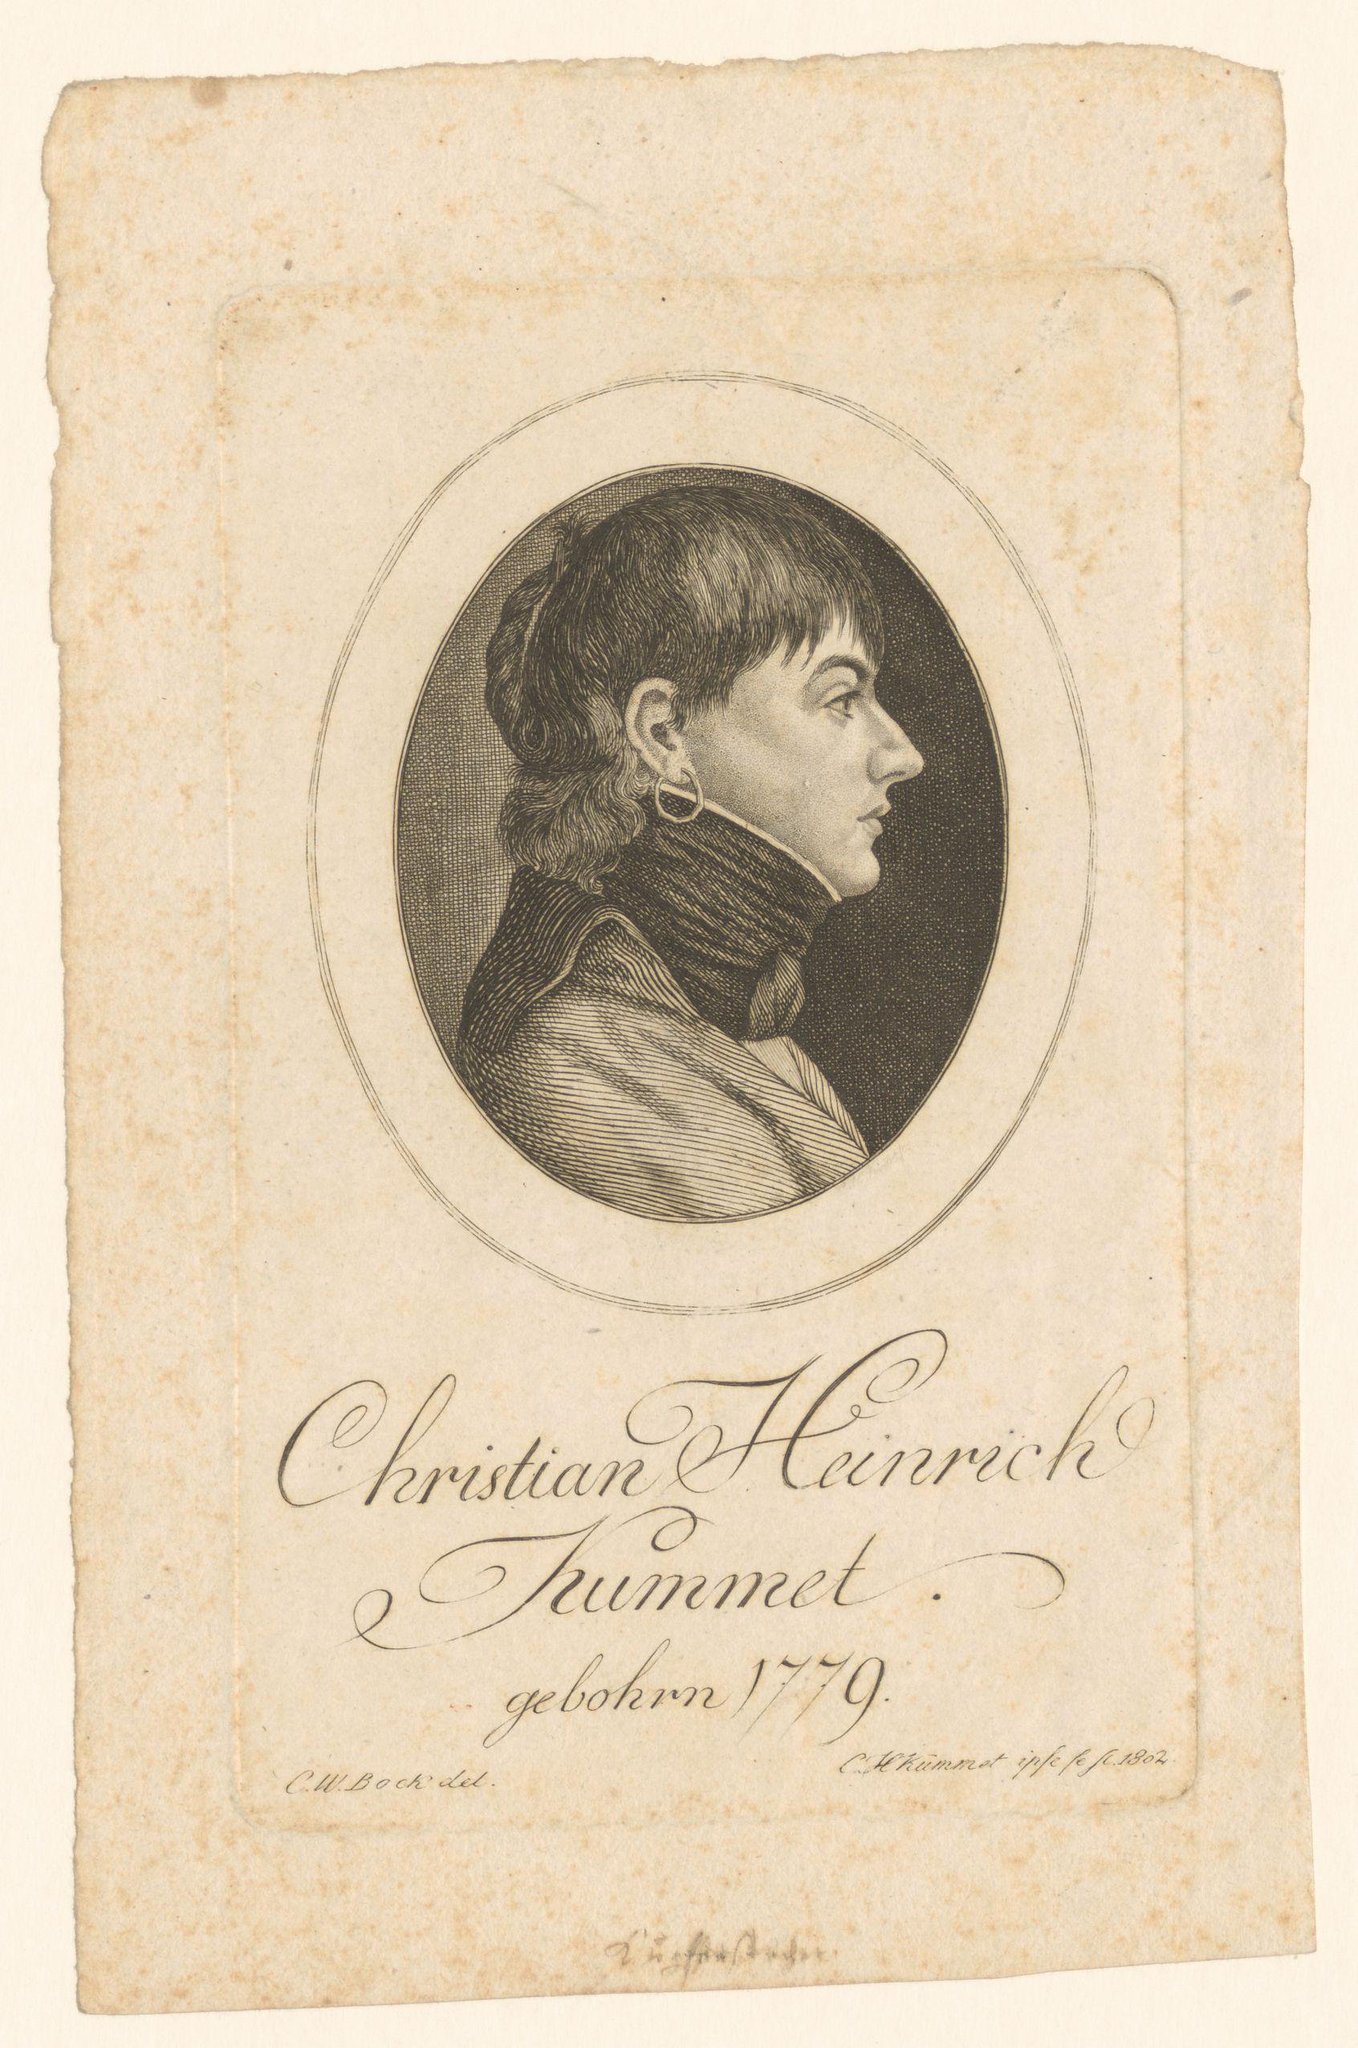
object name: print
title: Zelfportret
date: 1802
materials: paper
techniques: engraving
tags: print maker, christian heinrich kummet, historical persons, portrait, self-portrait of graphic artist, ear-rings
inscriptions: collector's mark: Lugt 2228